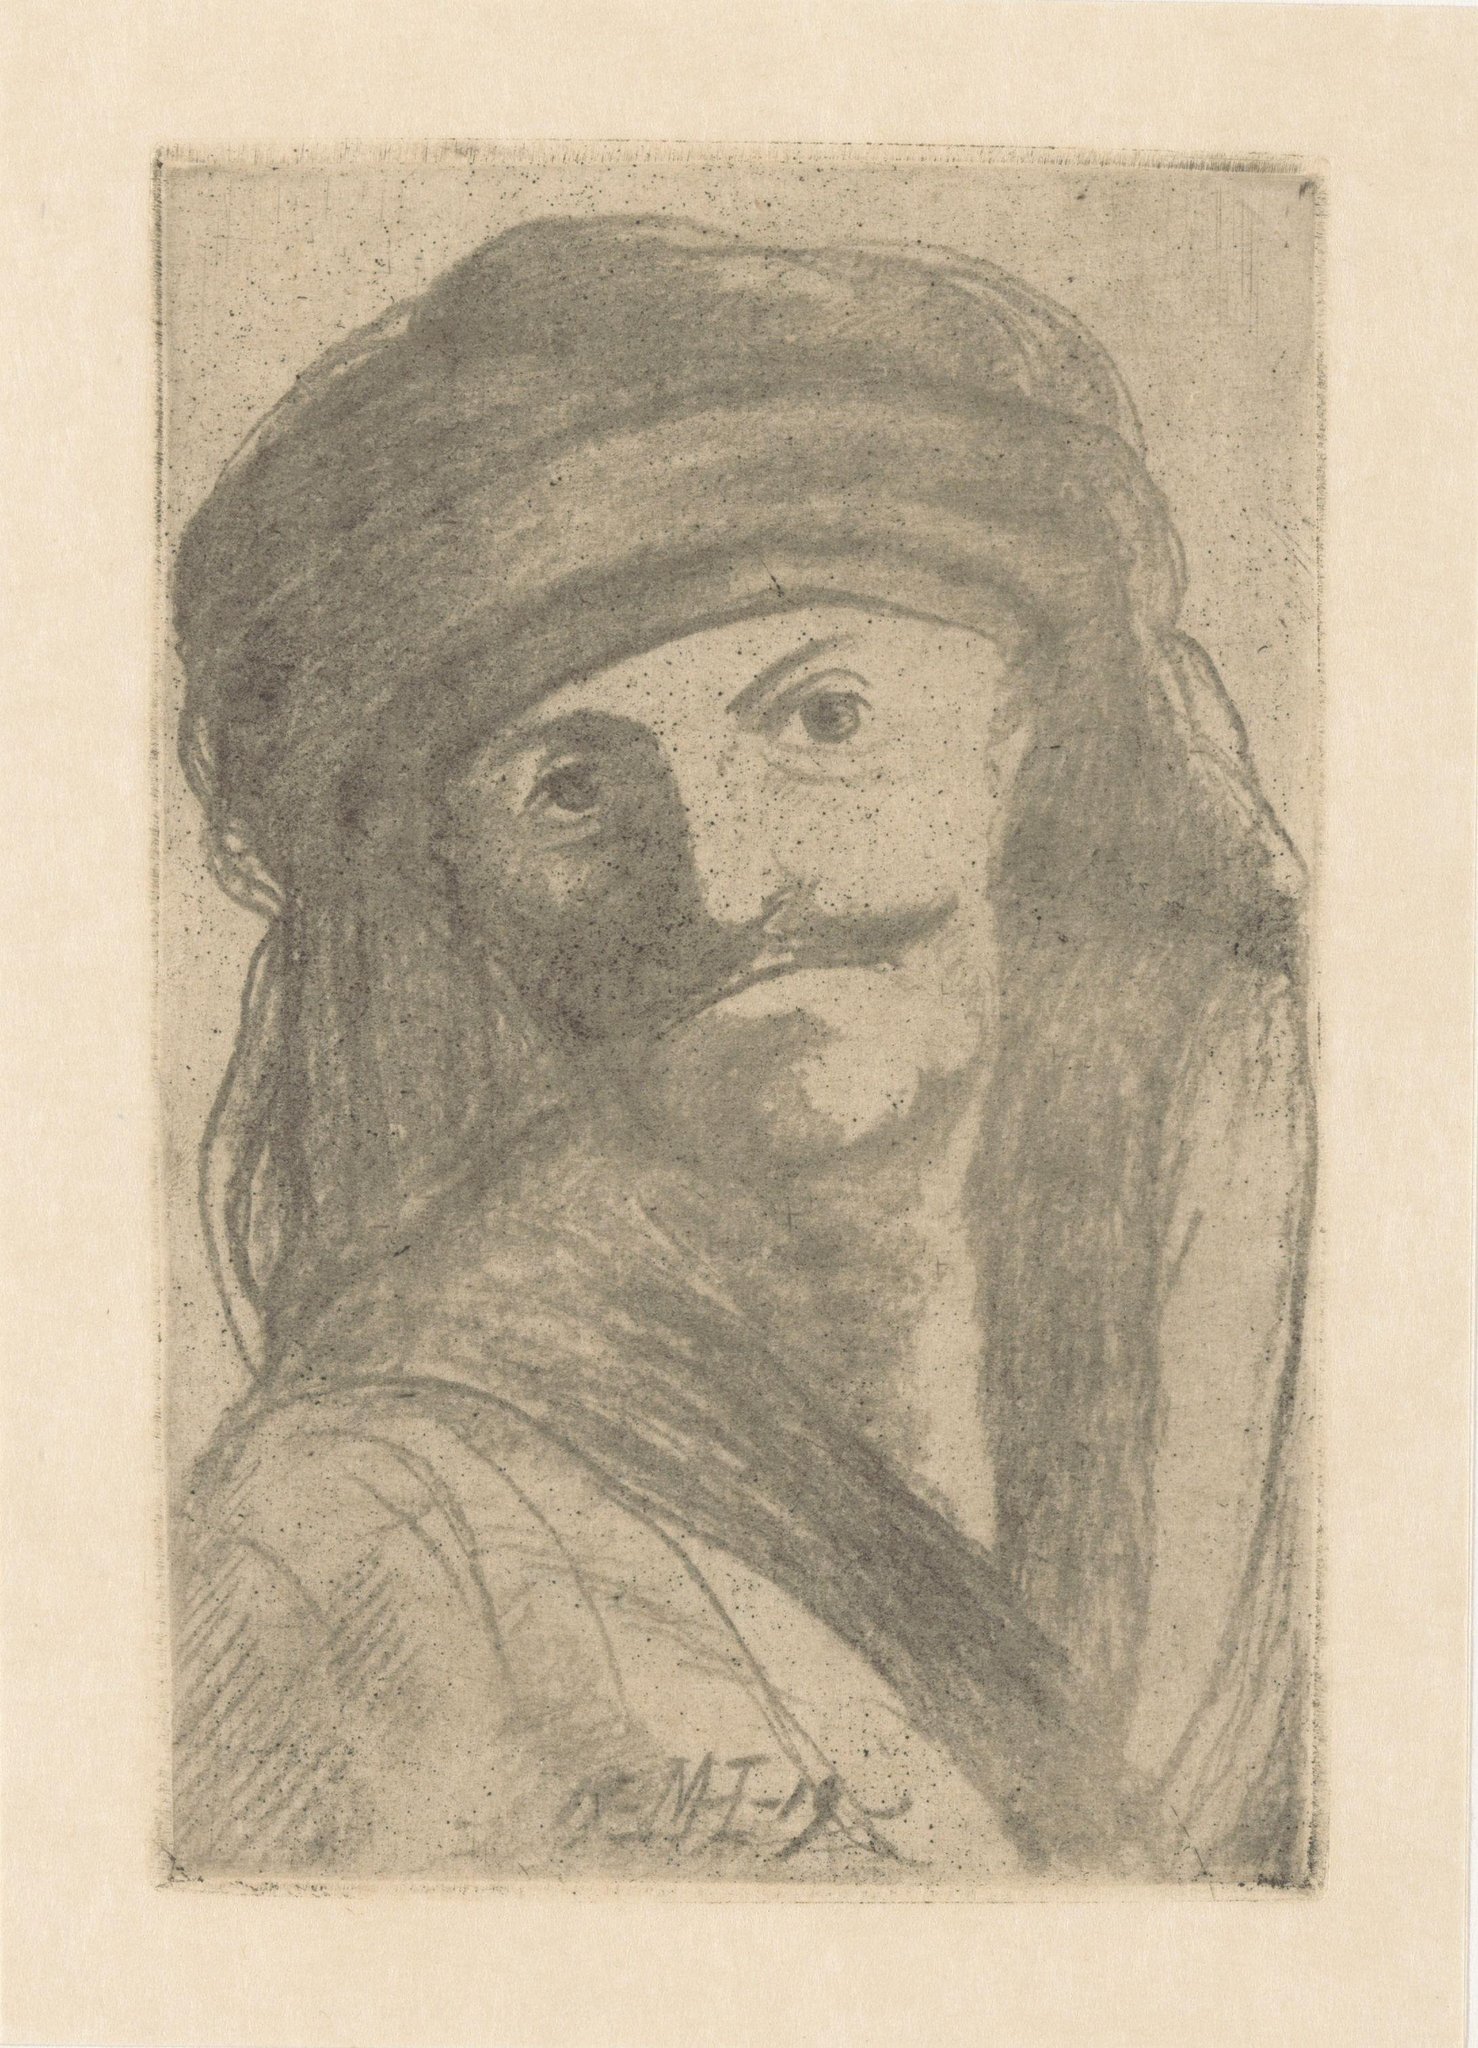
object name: print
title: Man met tulband en snor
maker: marius holleman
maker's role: draughtsman, print maker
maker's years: 1878-1926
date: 1919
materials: paper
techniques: etching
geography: groningen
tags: moustache, head-gear: turban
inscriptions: collector's mark: Lugt 2228